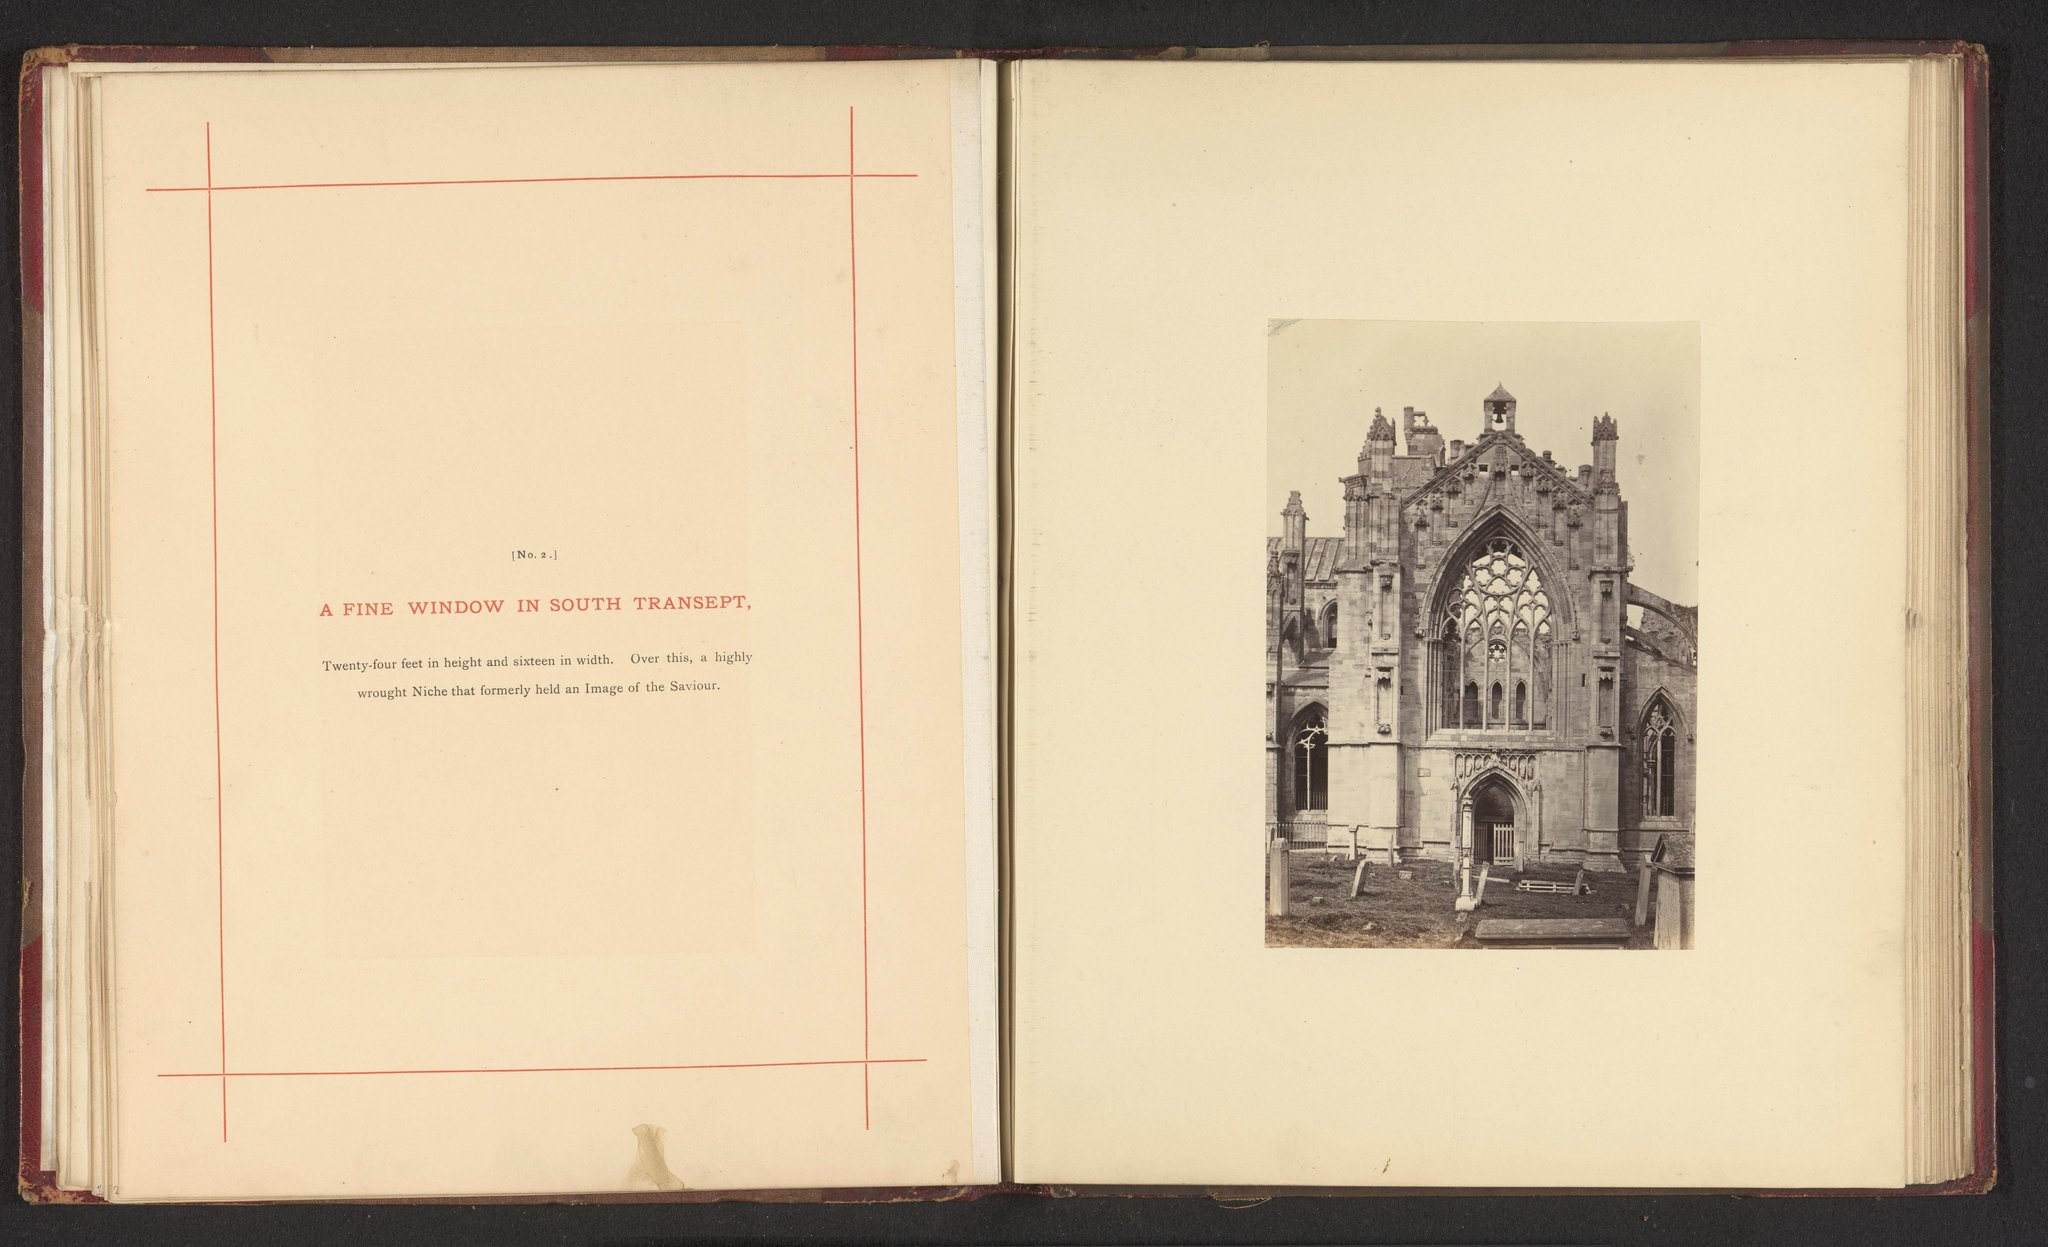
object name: photograph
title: Gezicht op een raam in een transept van de ruïne van Melrose Abbey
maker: w.j. pringle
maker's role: fotograaf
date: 1860-1870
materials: photographic support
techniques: albumen print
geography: melrose abbey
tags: church-window, e.g. rose-window, ruin of church, monastery, etc.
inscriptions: inscription: ‘Twenty-four feet in height and sixteen in width. Over this, a highly wrought Niche that formerly held an Image of the Saviour.’, title: ‘A fine window in south transept’, number: ‘(No. 2.)’